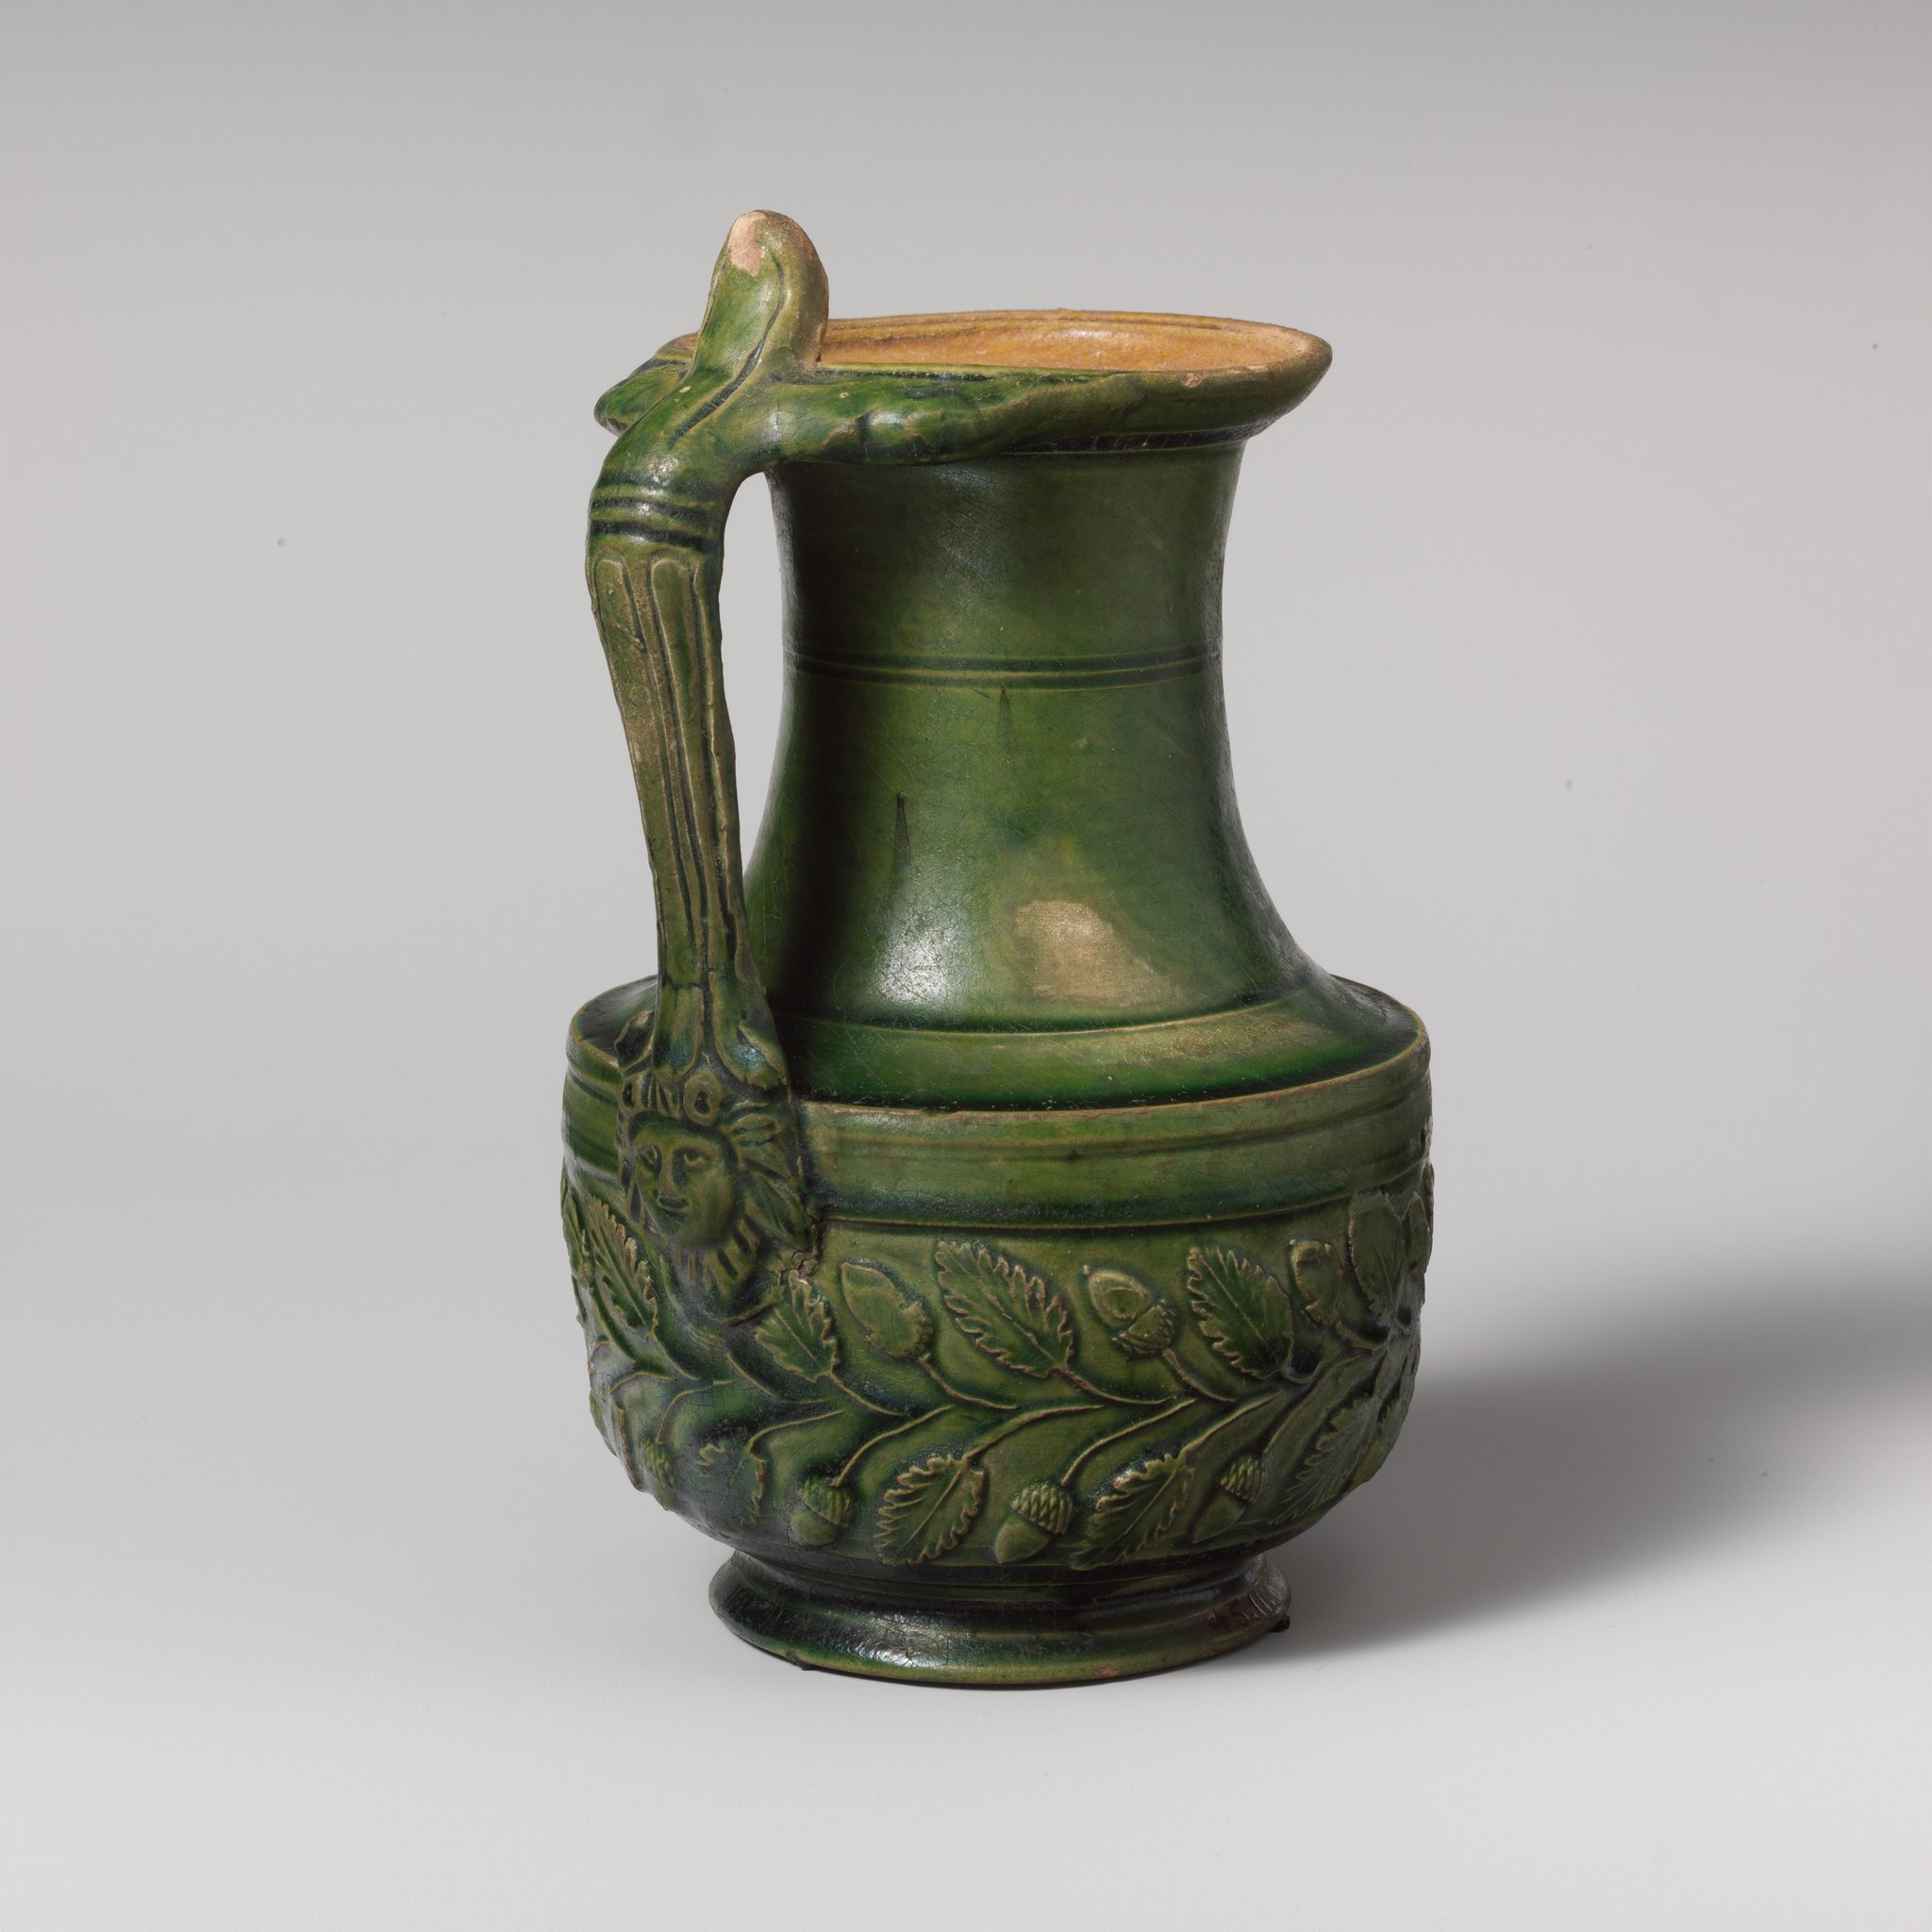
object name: jug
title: Terracotta jug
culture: roman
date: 1-50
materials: terracotta